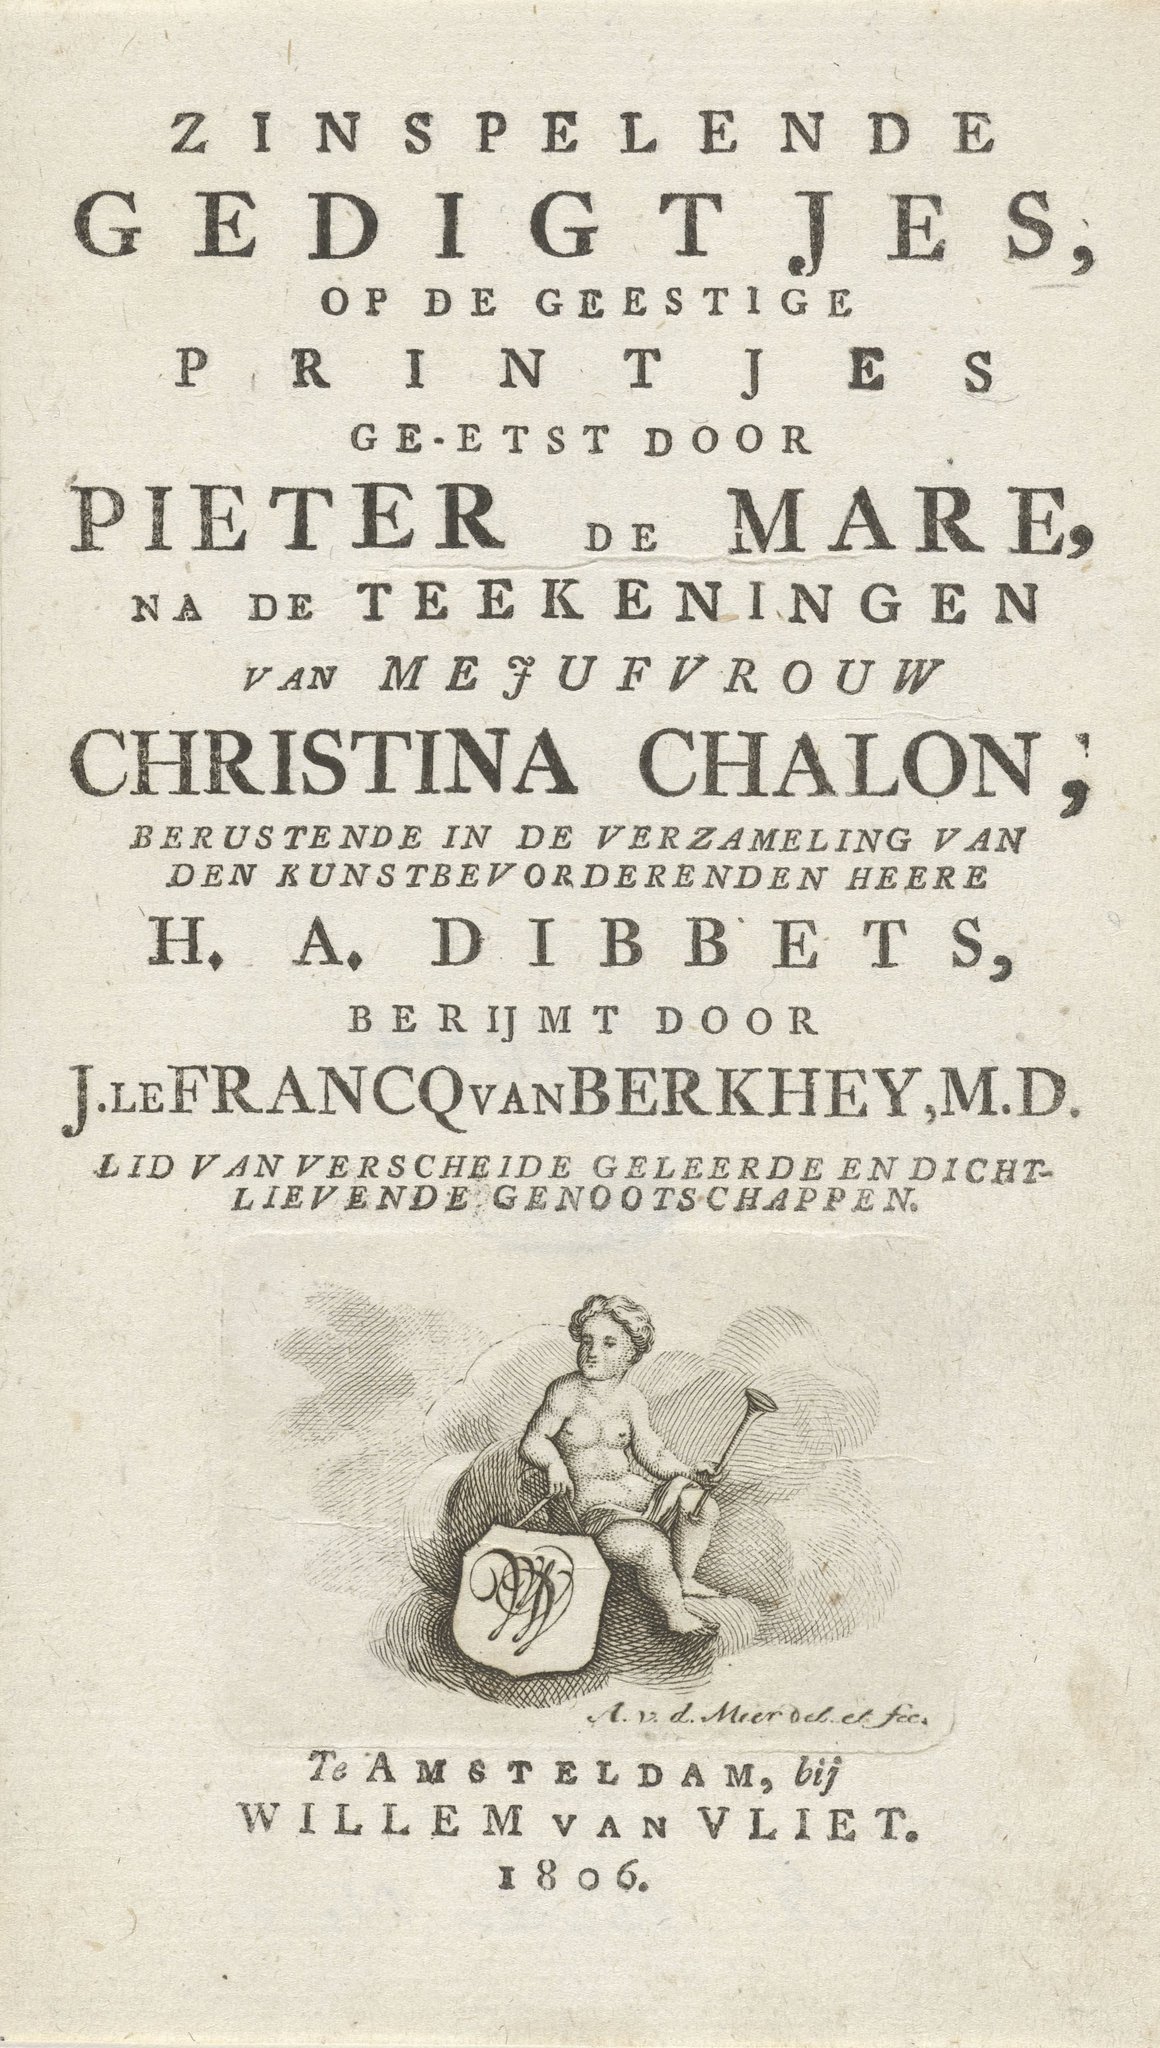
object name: titelblad, titelpagina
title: Putto met een trompet en wapenschild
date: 1806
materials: paper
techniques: etching, letterpress printing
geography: amsterdam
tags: horn, trumpet, cornet, trombone, tuba, cupids: 'amores', 'amoretti', 'putti'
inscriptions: collector's mark: Lugt 2228, collector's mark: Lugt 2760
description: Titelpagina voor: Le Francq van Berkhey, Joannes. Zinspelende gedigtjes, op de geestige printjes ge-etst door Pieter de Mare, na de teekeningen van mejuffrouw Christina Chalon, berustende in de verzameling van (...) H.A. Dibbets. Amsterdam: Willem van Vliet, 1806.